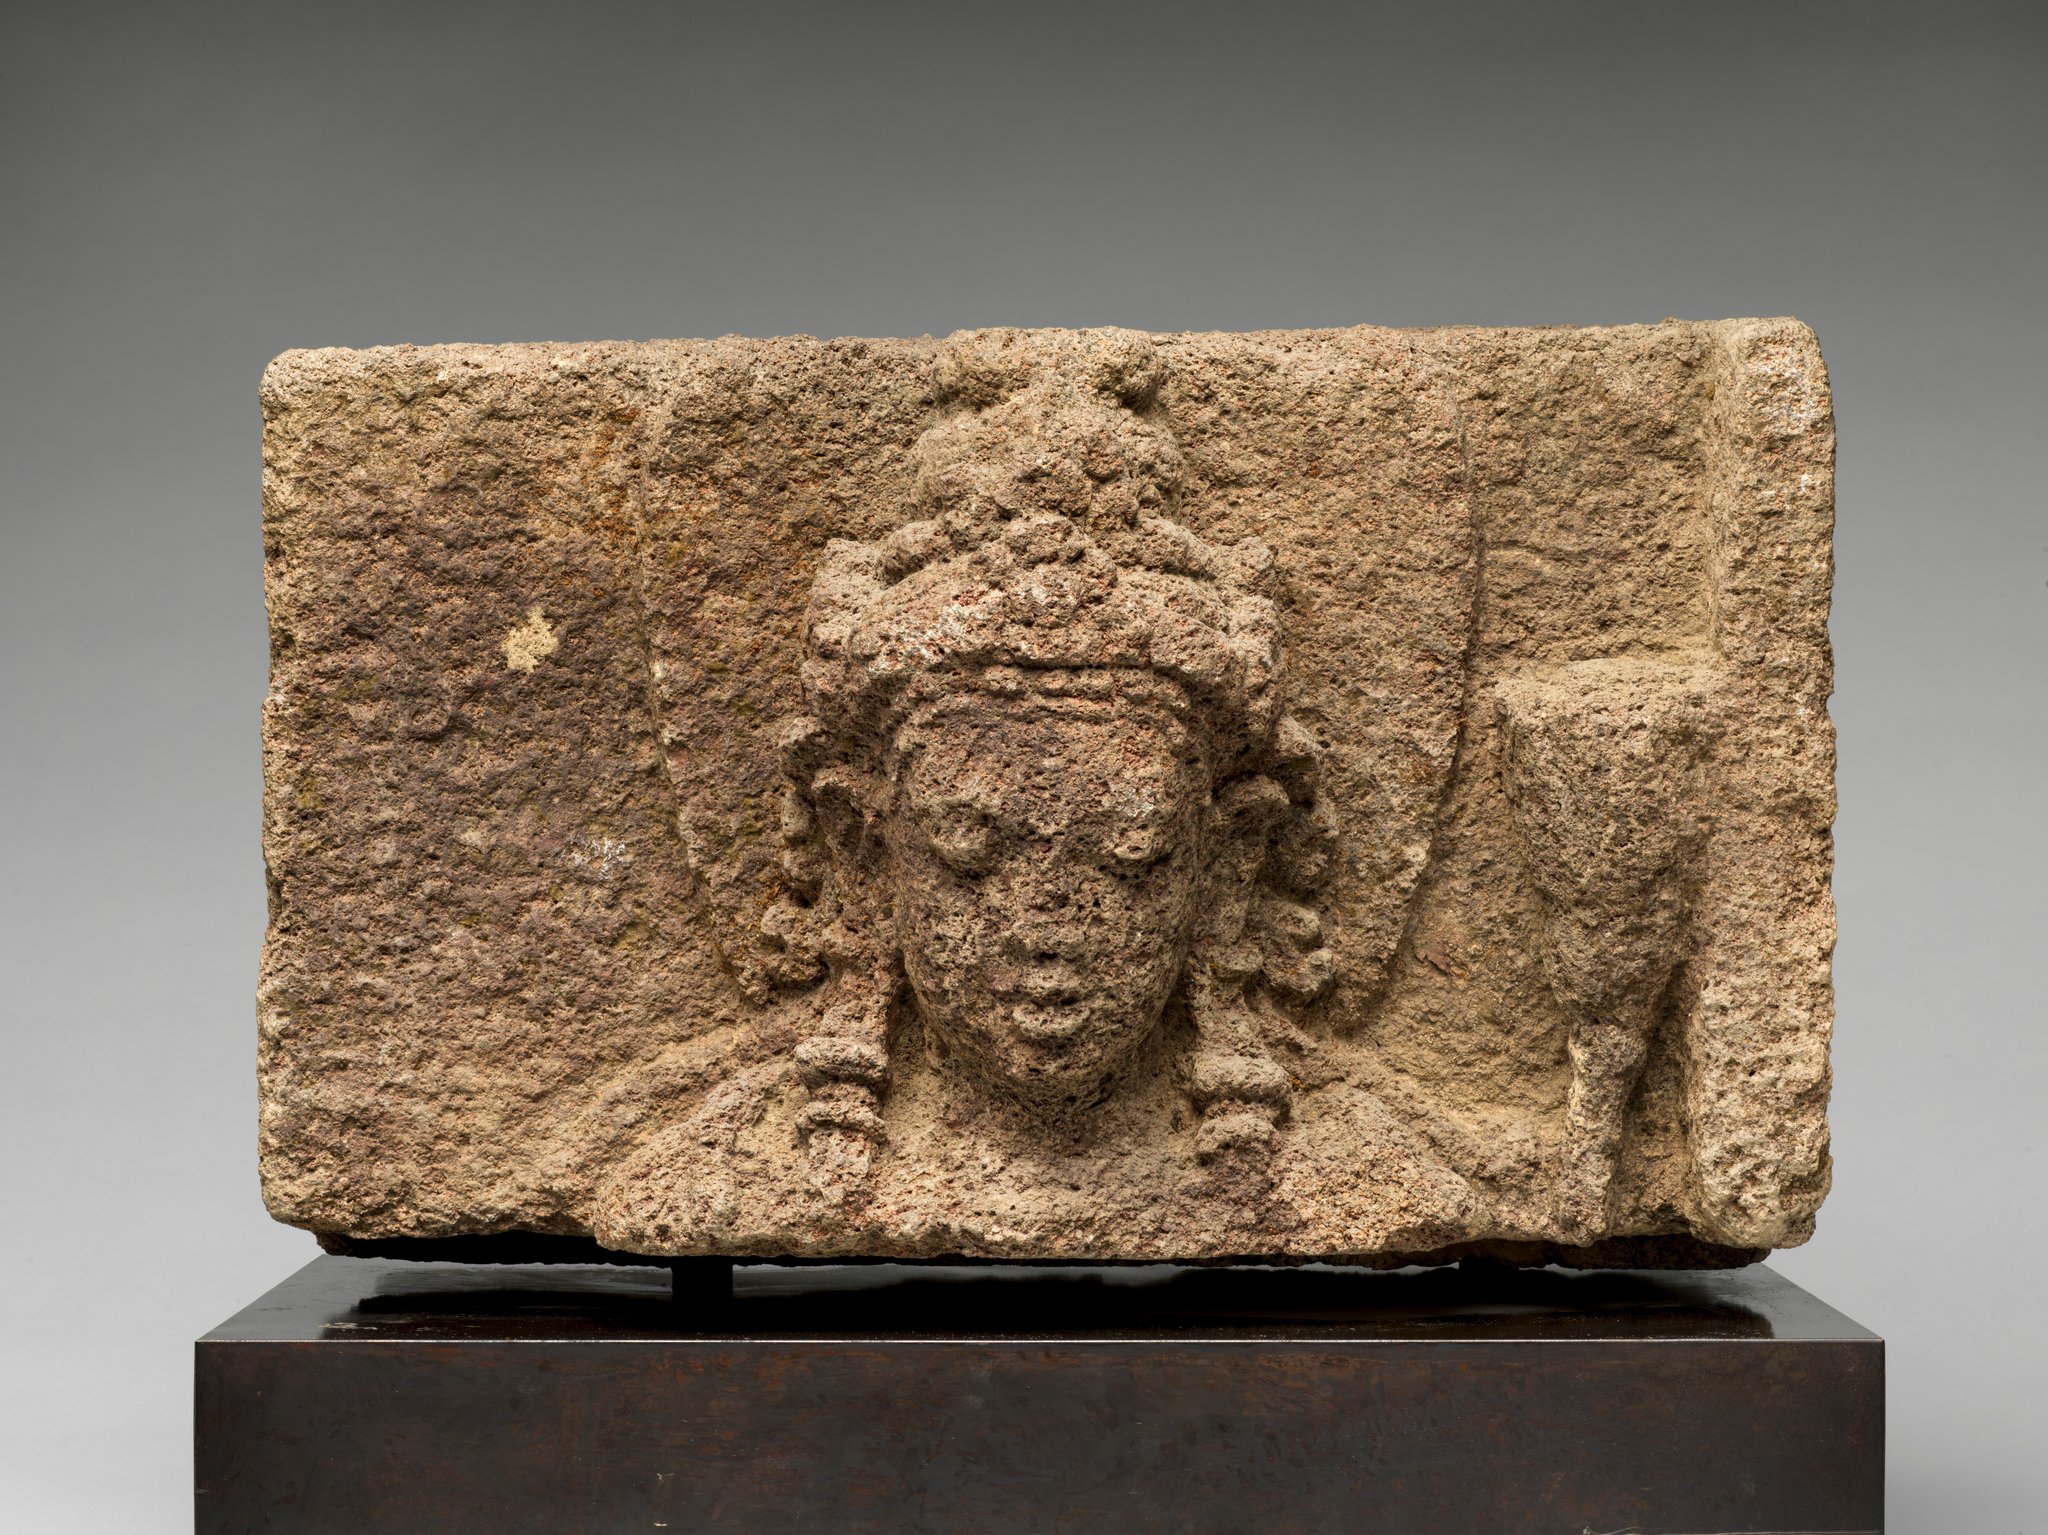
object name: relief fragment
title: Head of a Bodhisattva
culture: indonesian, javanese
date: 901-1000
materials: stone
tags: buddhism,bodhisattvas